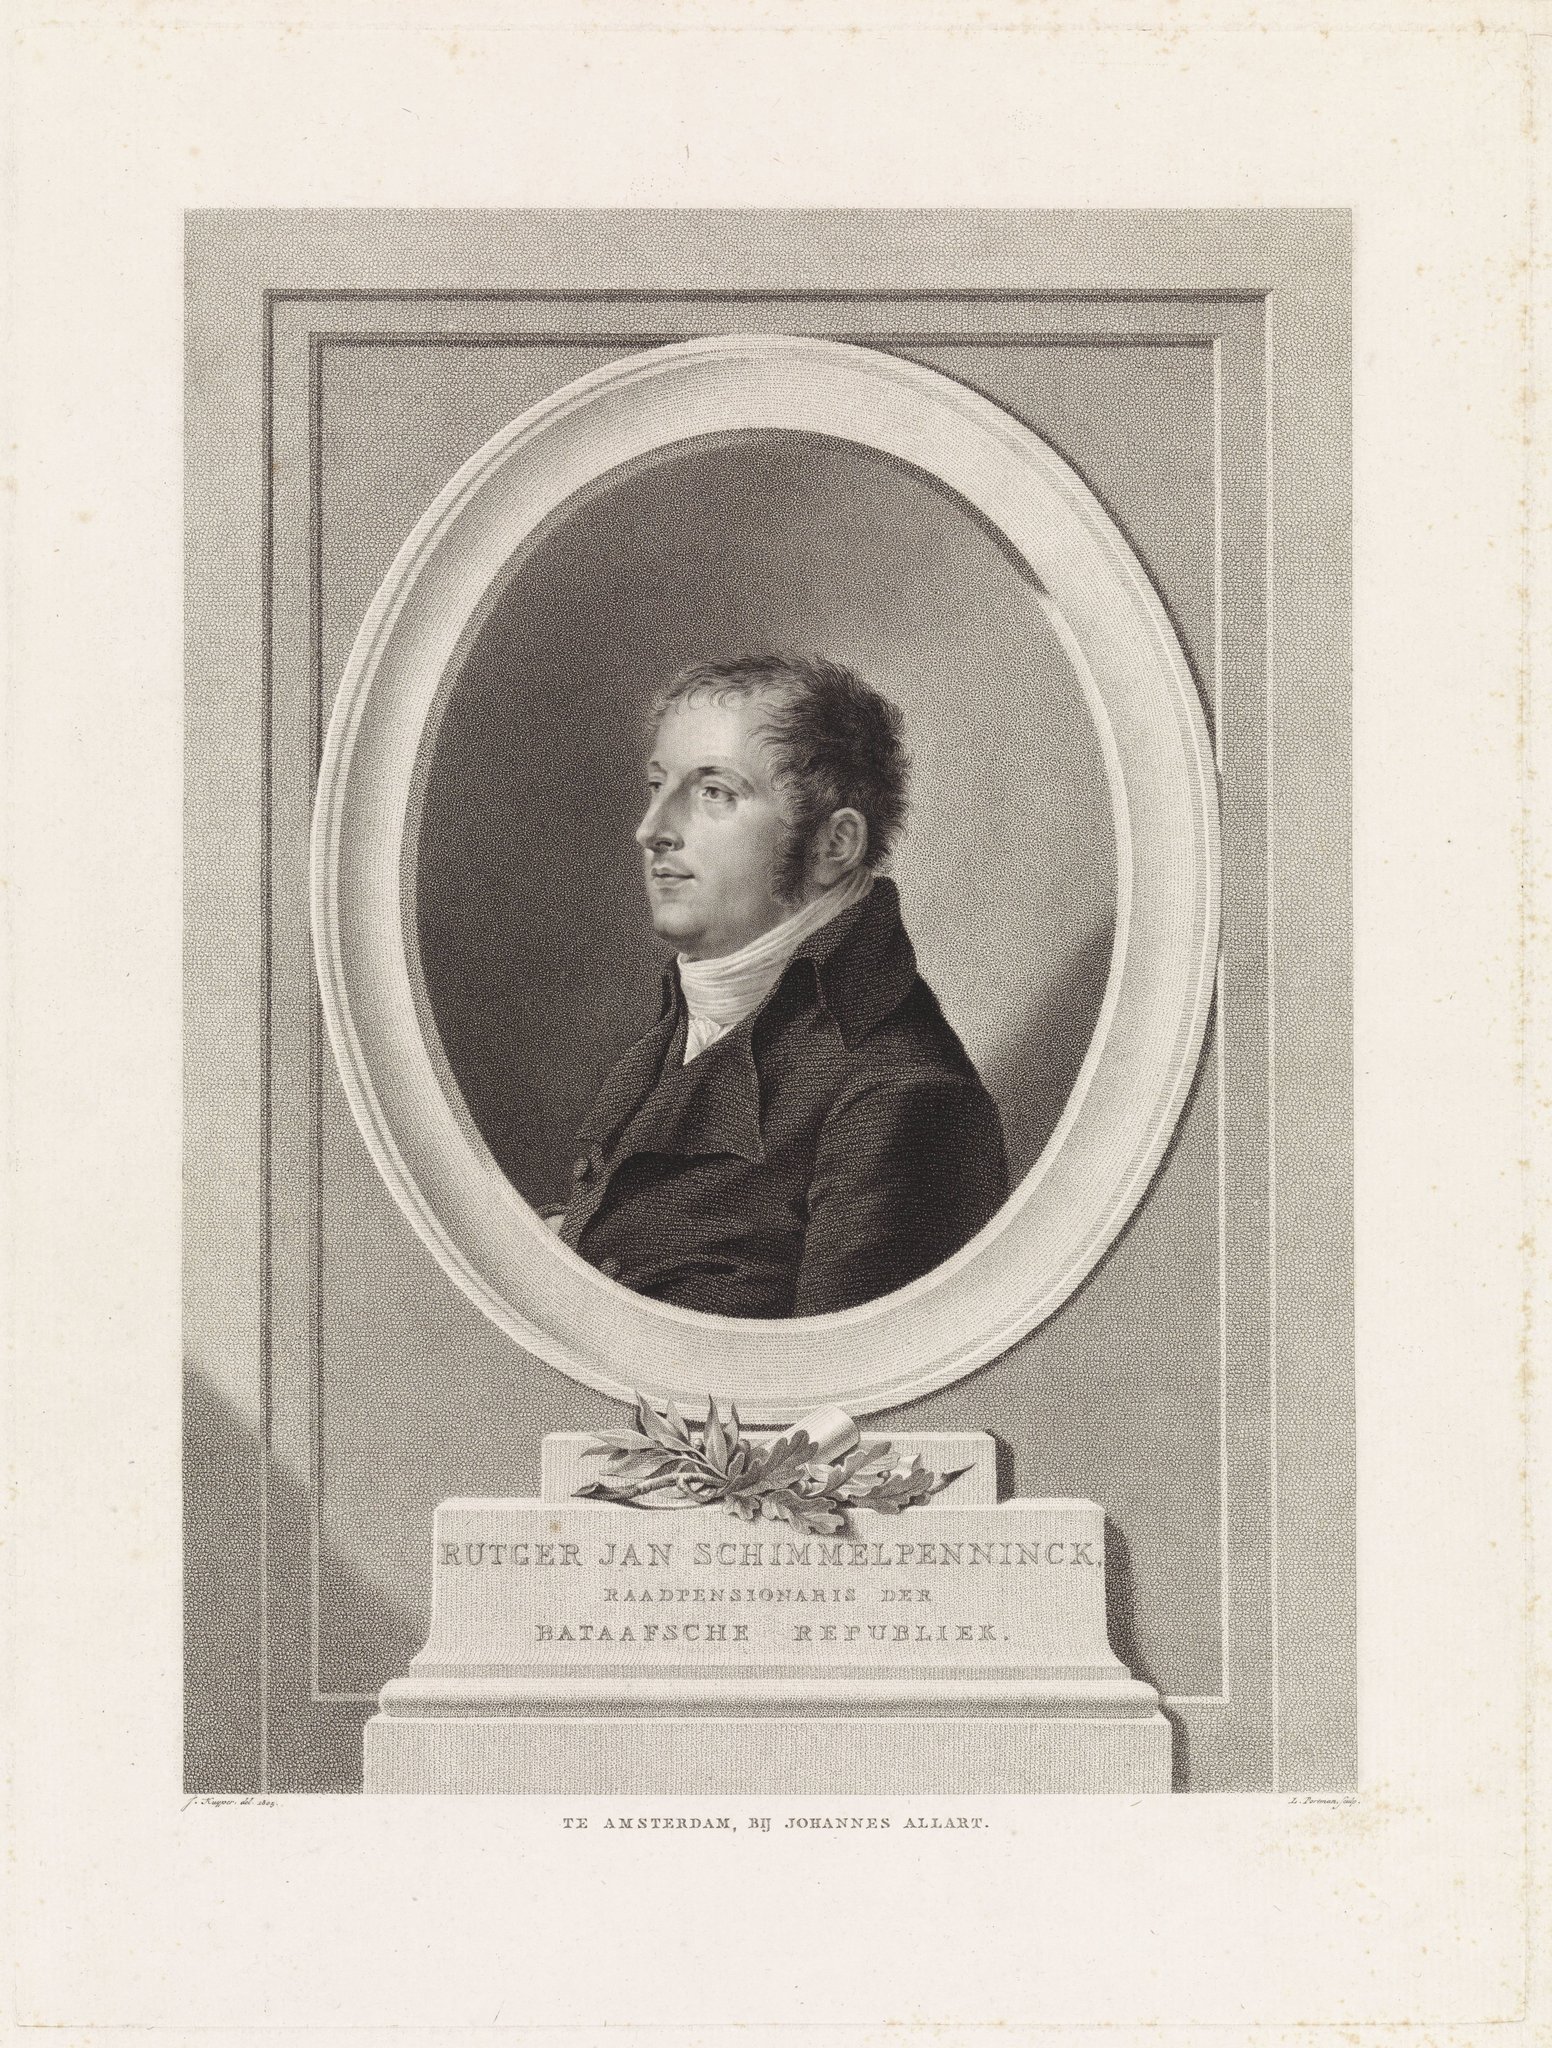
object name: print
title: Portret van Rutger Jan Schimmelpenninck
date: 1805-1817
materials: paper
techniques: engraving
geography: amsterdam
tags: deventer, amsterdam, rutger jan schimmelpenninck (1761-1825), historical persons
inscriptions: collector's mark: Lugt 2228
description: Portret van Rutger Jan Schimmelpenninck, raadspensionaris van de Bataafse Republiek, in een ovaal. Onder het portret zijn naar en functie in drie regels in het Nederlands.